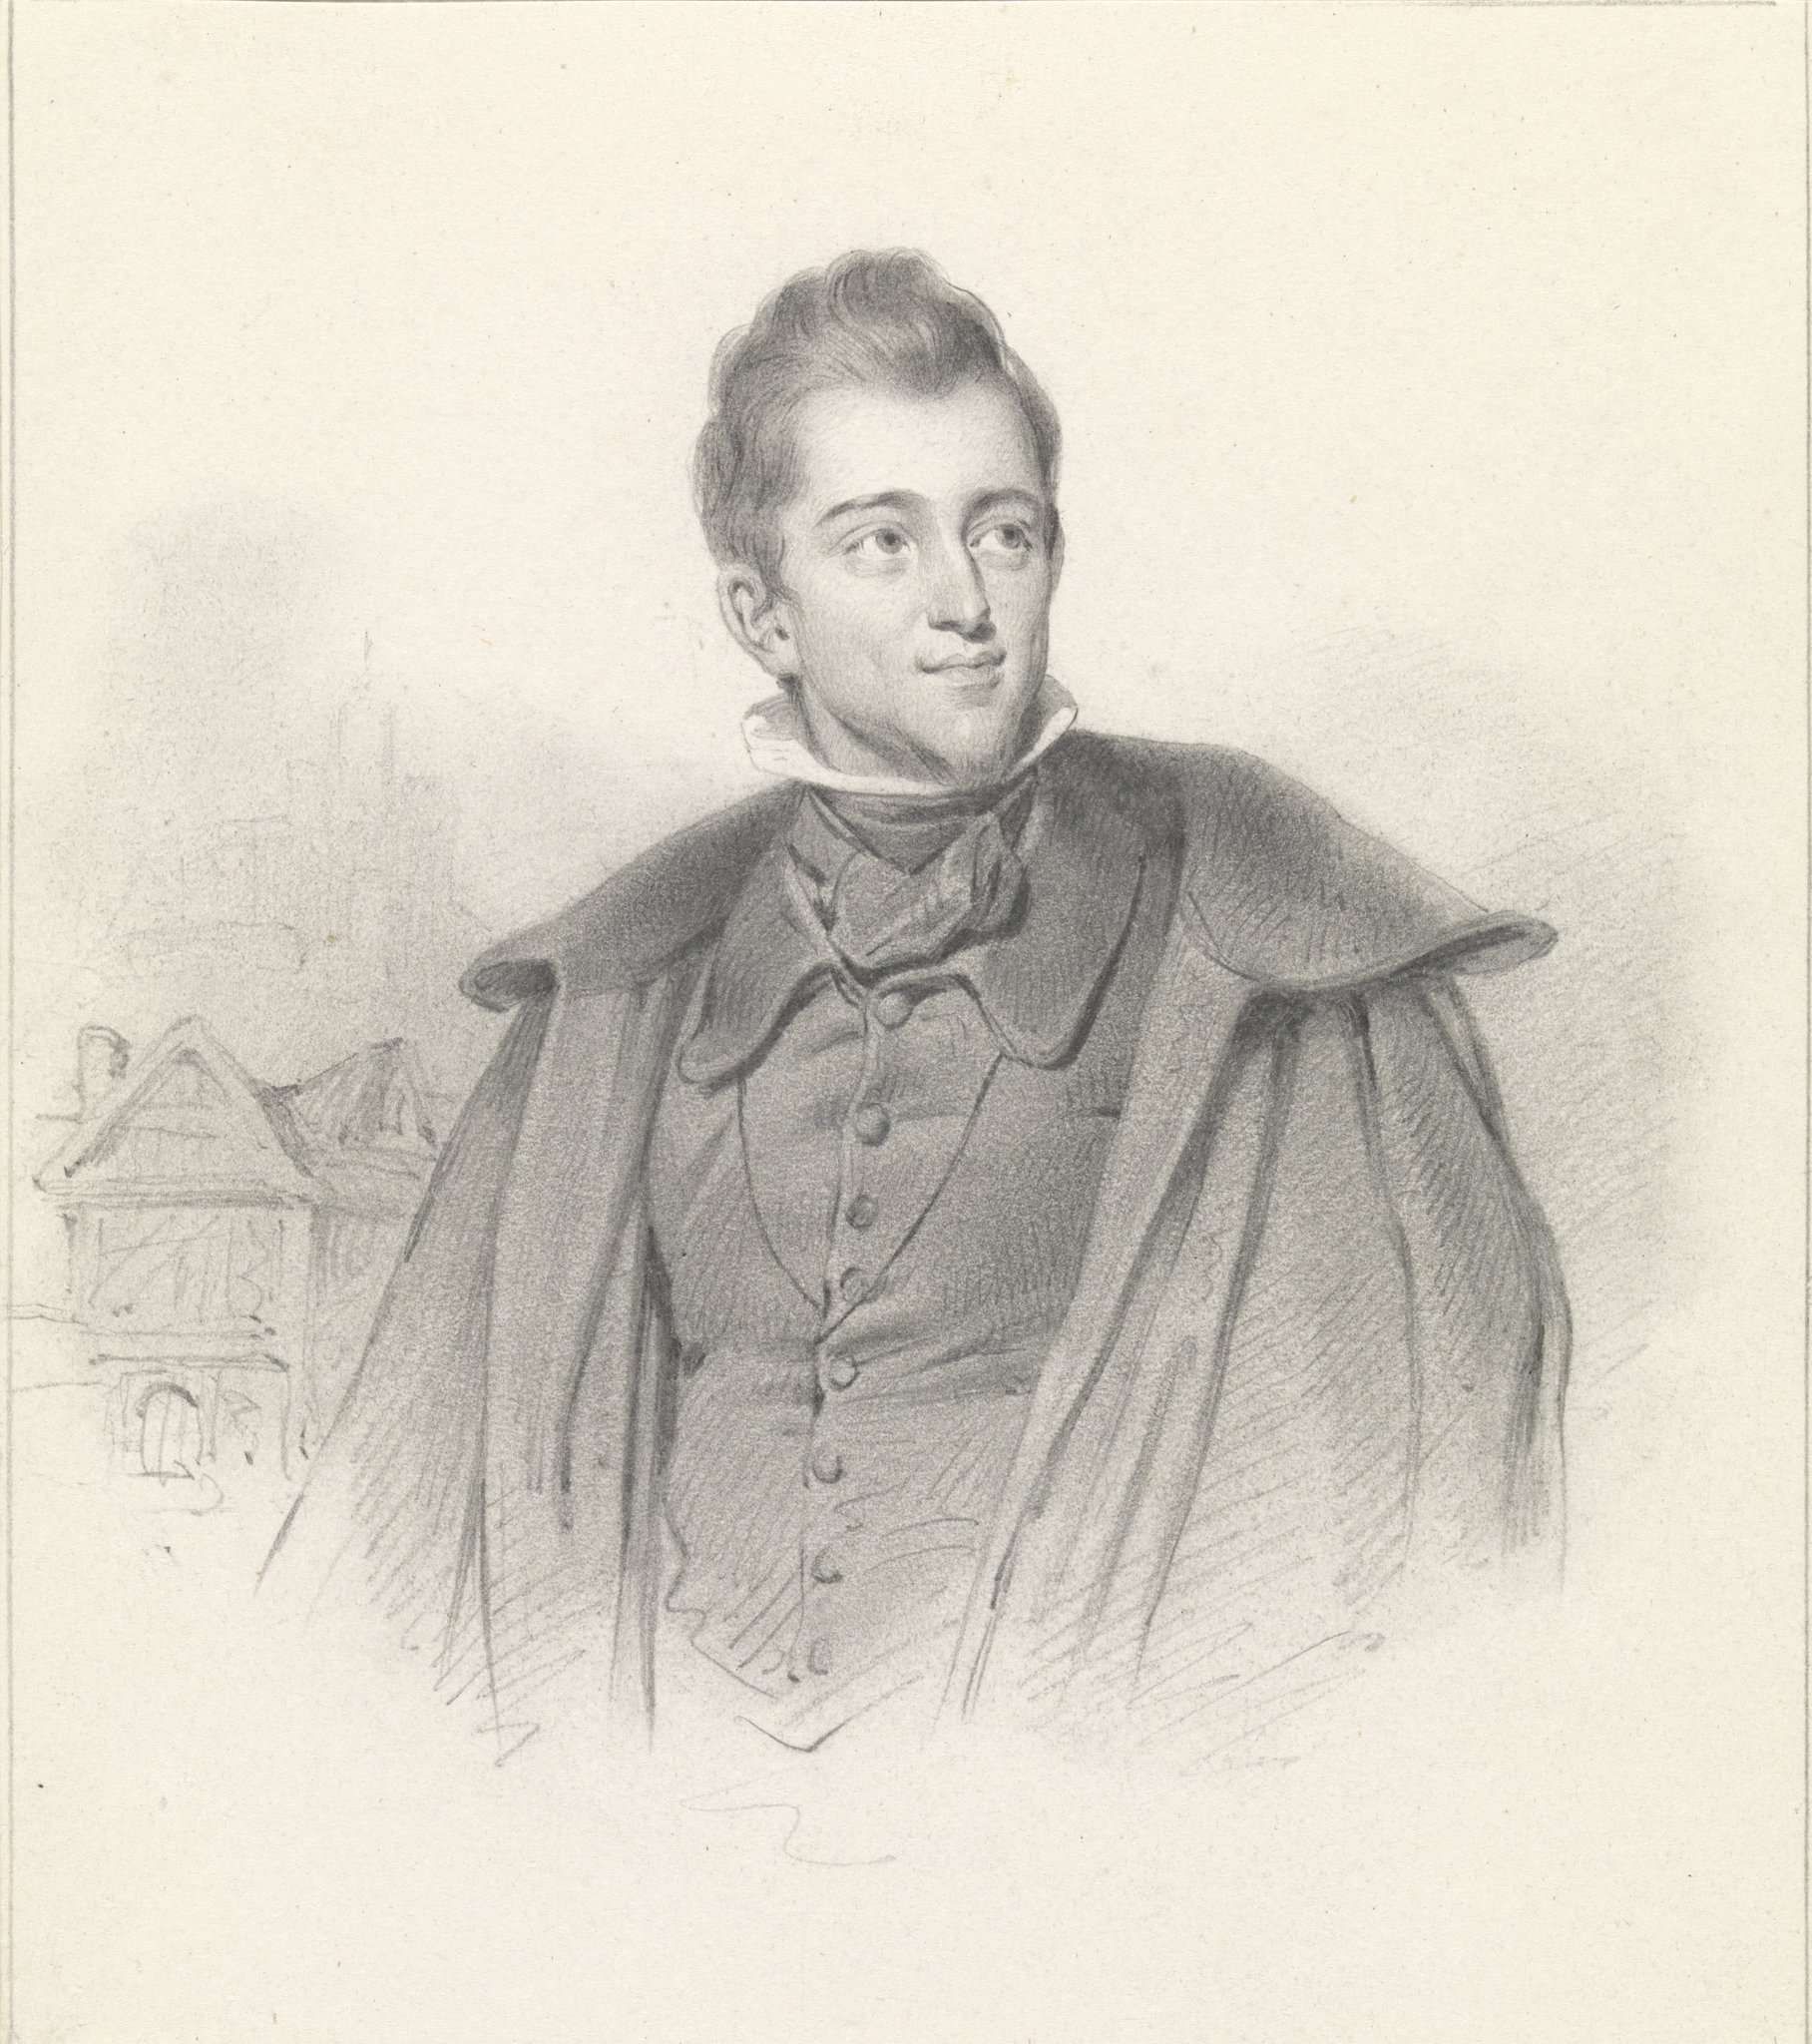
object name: drawing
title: Portret van Johannes Bosboom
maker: lodewijk anthony vintcent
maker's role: draughtsman, print maker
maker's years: 1812-1842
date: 1841-1842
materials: paper, pencil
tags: painter, johannes bosboom, historical persons, portrait, self-portrait of painter, portrait, self-portrait of artist, portrait, self-portrait of draughtsman